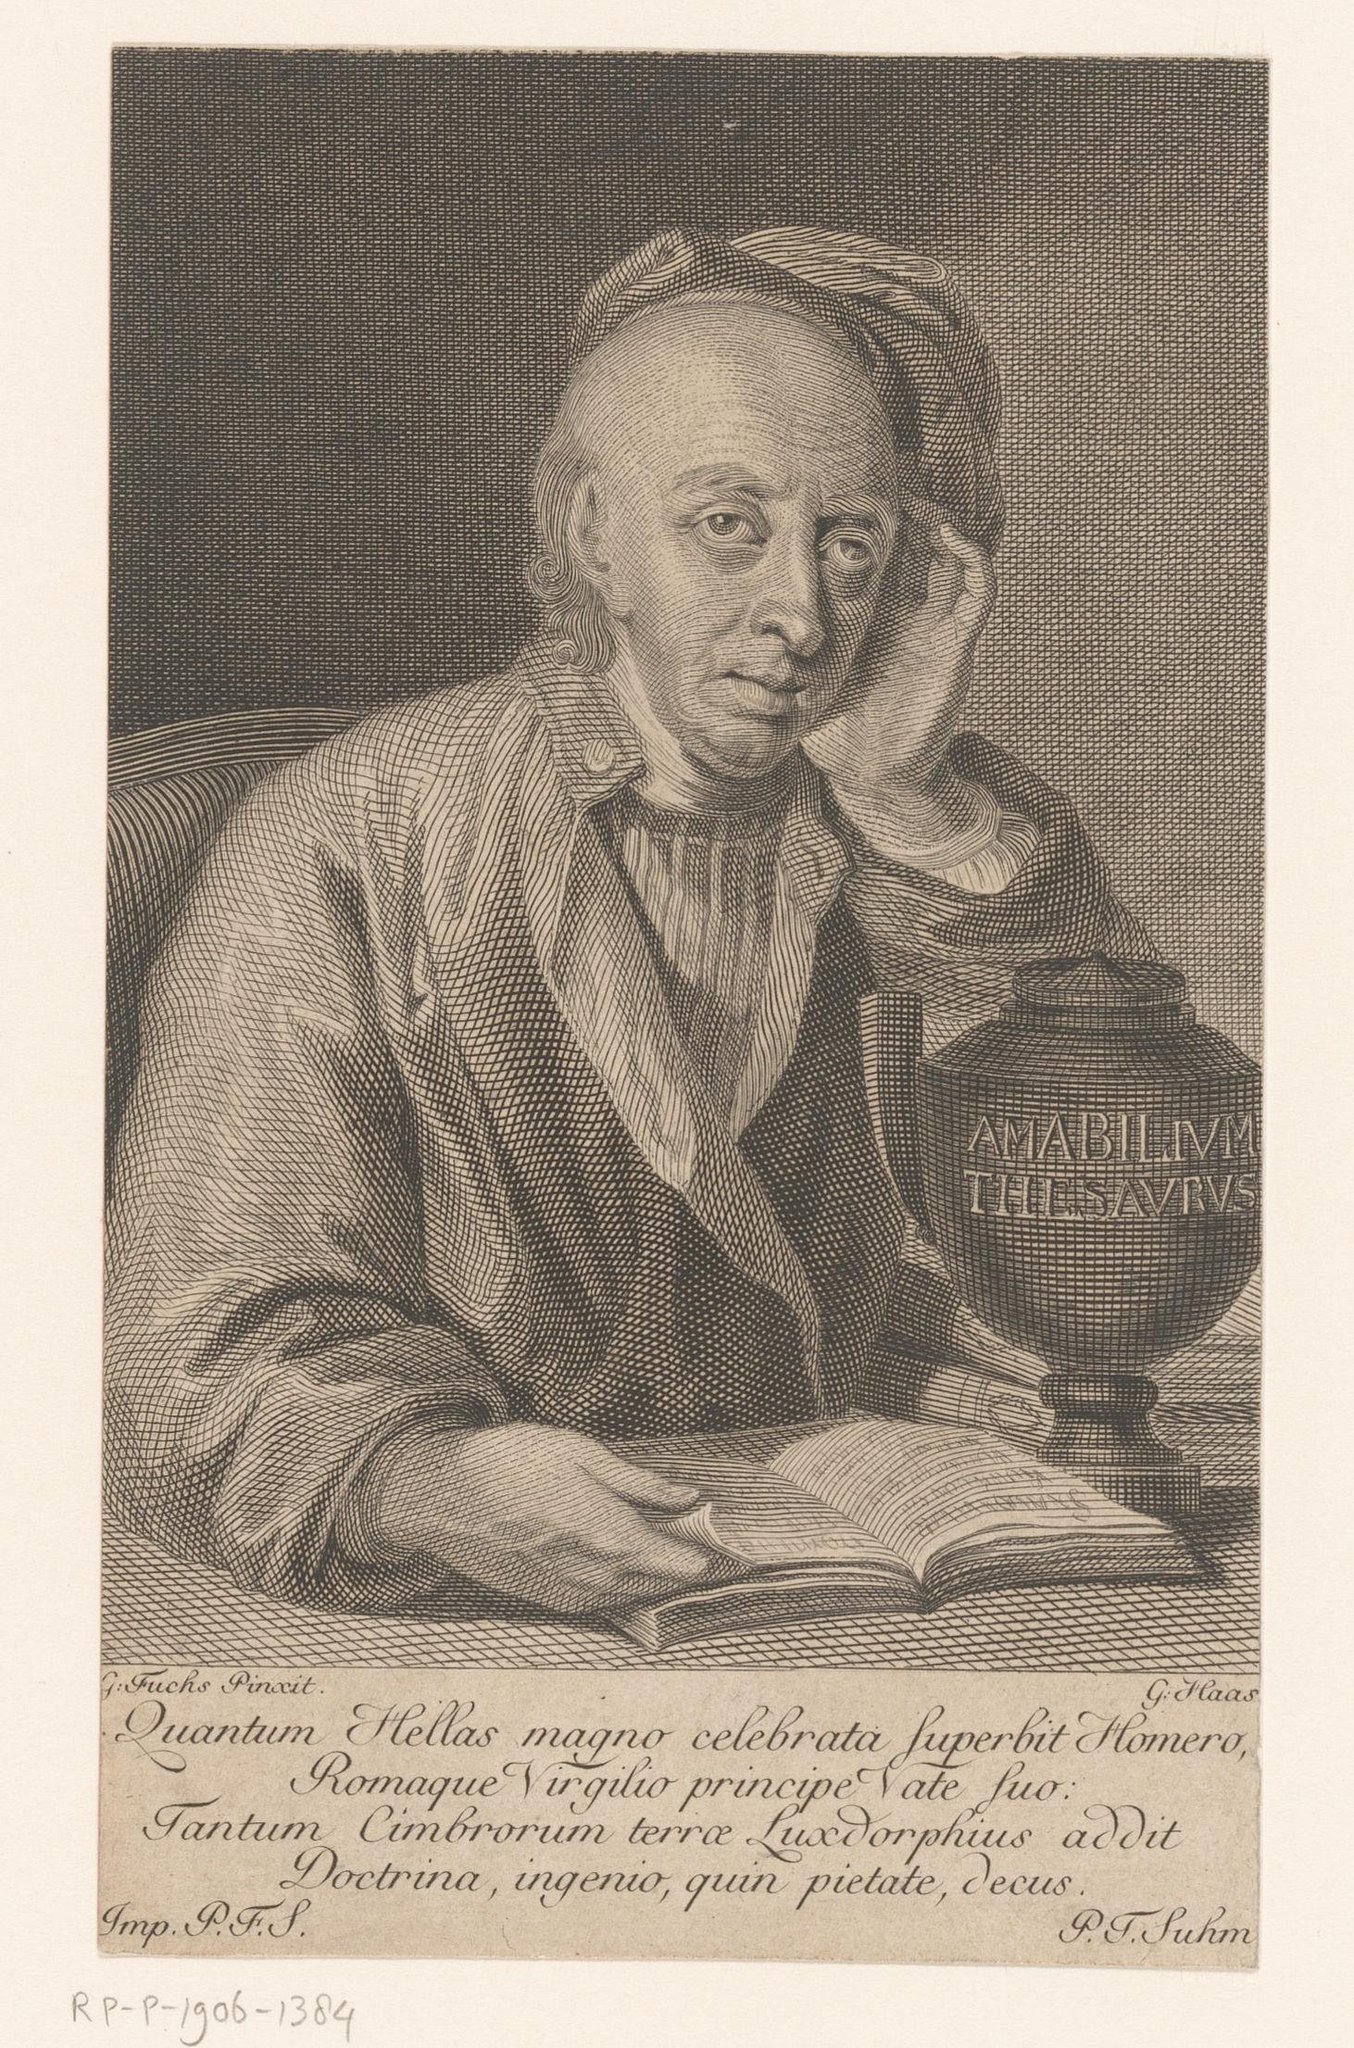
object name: print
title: Portret van Bolle Willum Luxdorph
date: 1782-1818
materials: paper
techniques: engraving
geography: denmark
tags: historical persons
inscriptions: collector's mark: Lugt 2228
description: Portret van de Deense jurist Bolle Willum Luxdorph, zittend aan tafel met een boek en een urn voor zich. Met vierregelig Latijns vers.